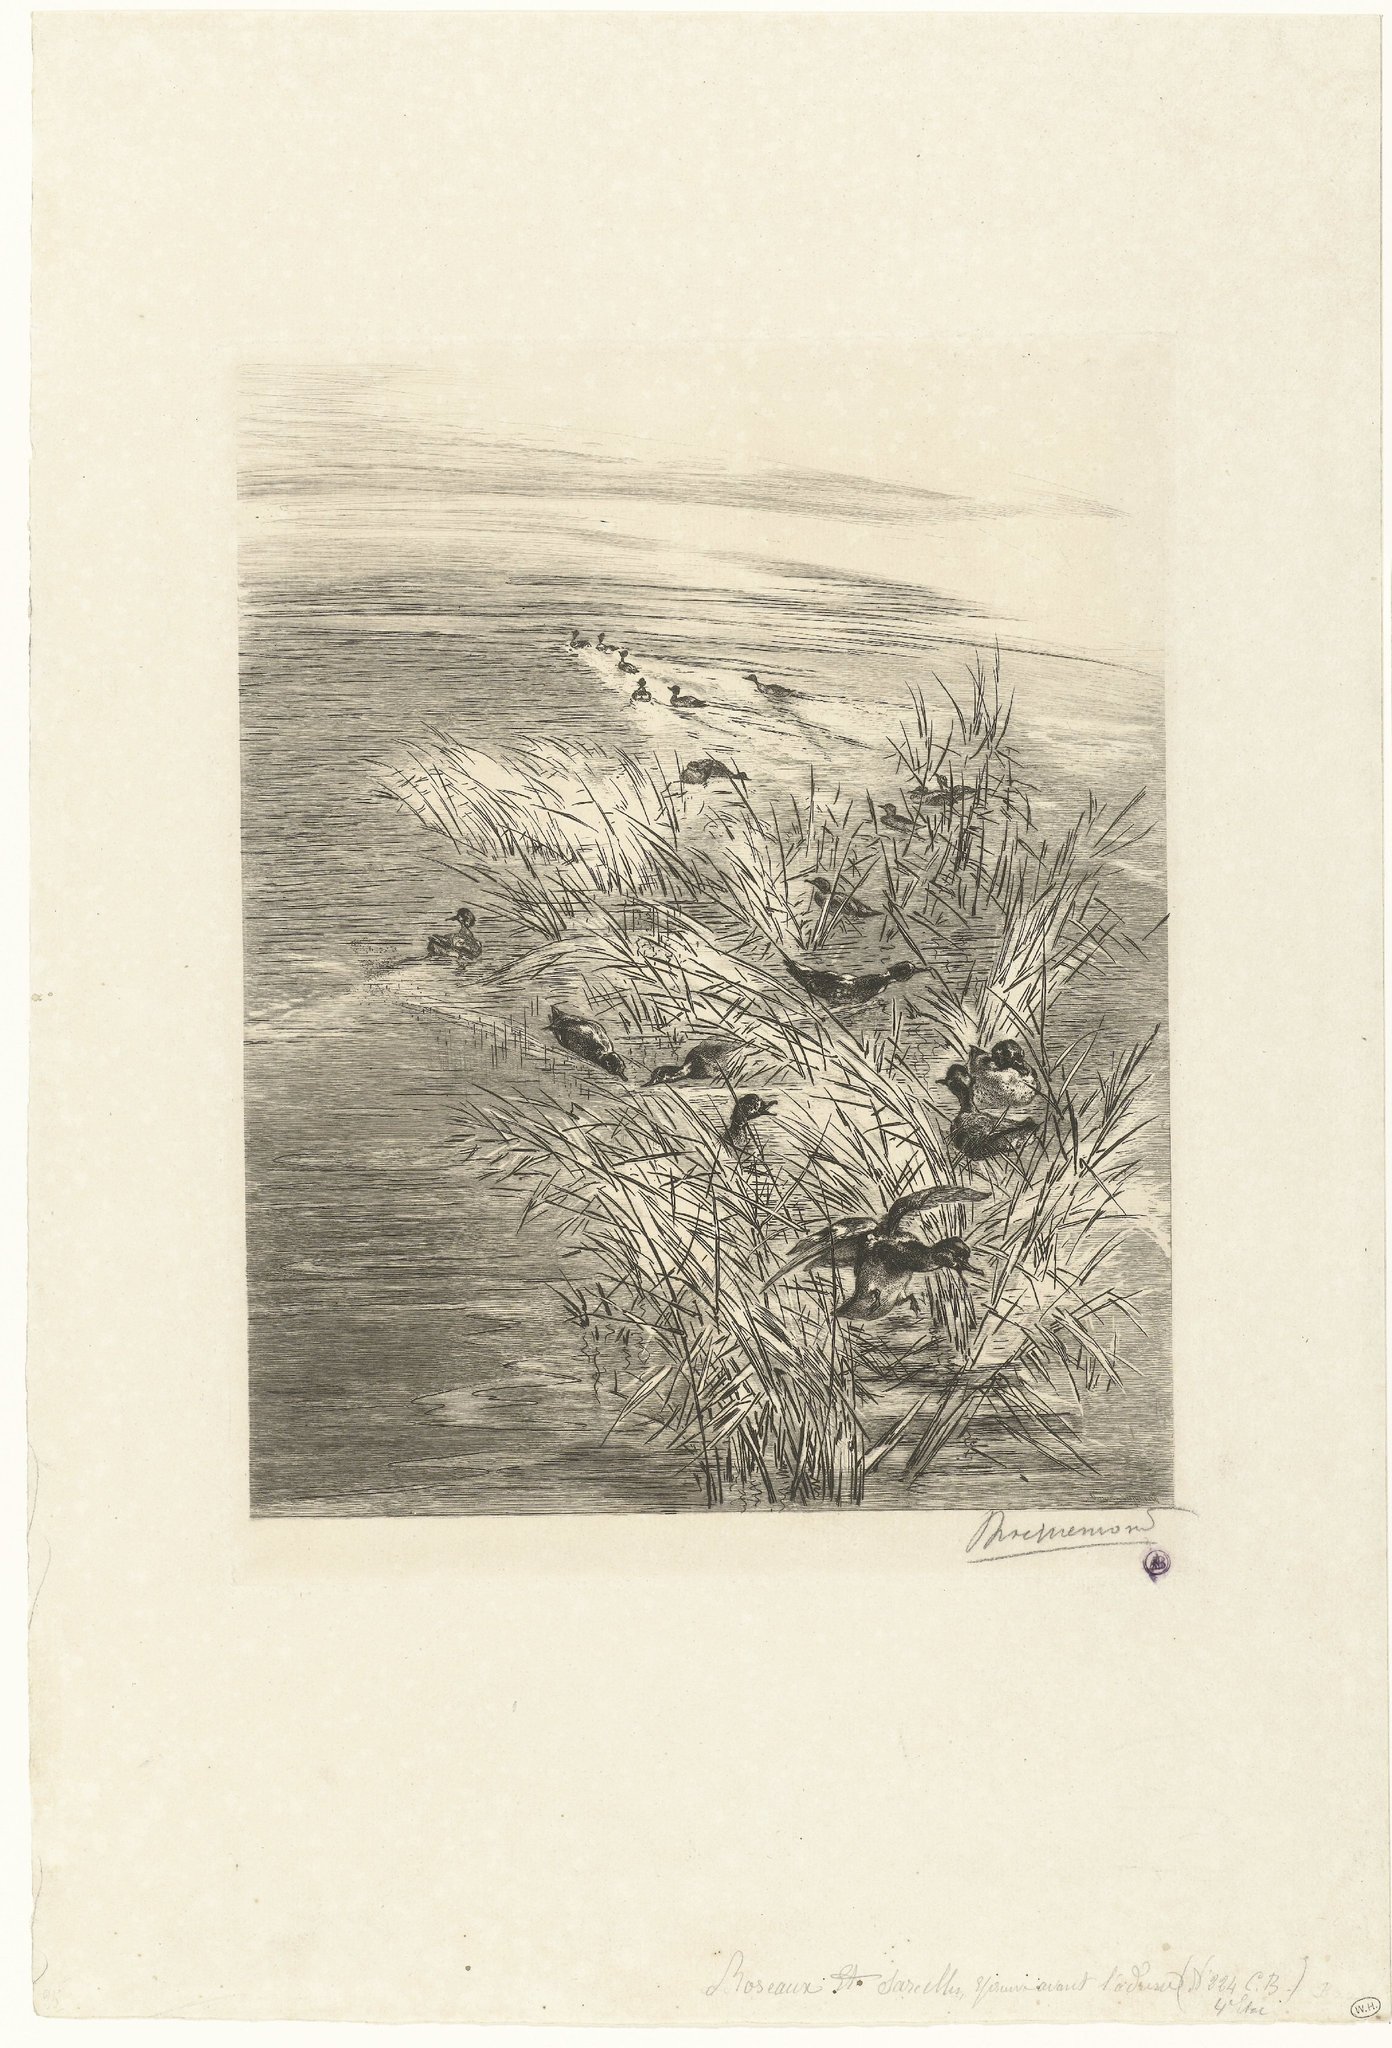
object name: print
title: Roseaux et sarcelles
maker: félix bracquemond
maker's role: print maker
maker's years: 1833-1914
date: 1860-1914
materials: paper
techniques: etching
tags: water-birds: duck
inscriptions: collector's mark: Lugt 2625, collector's mark: Lugt 76